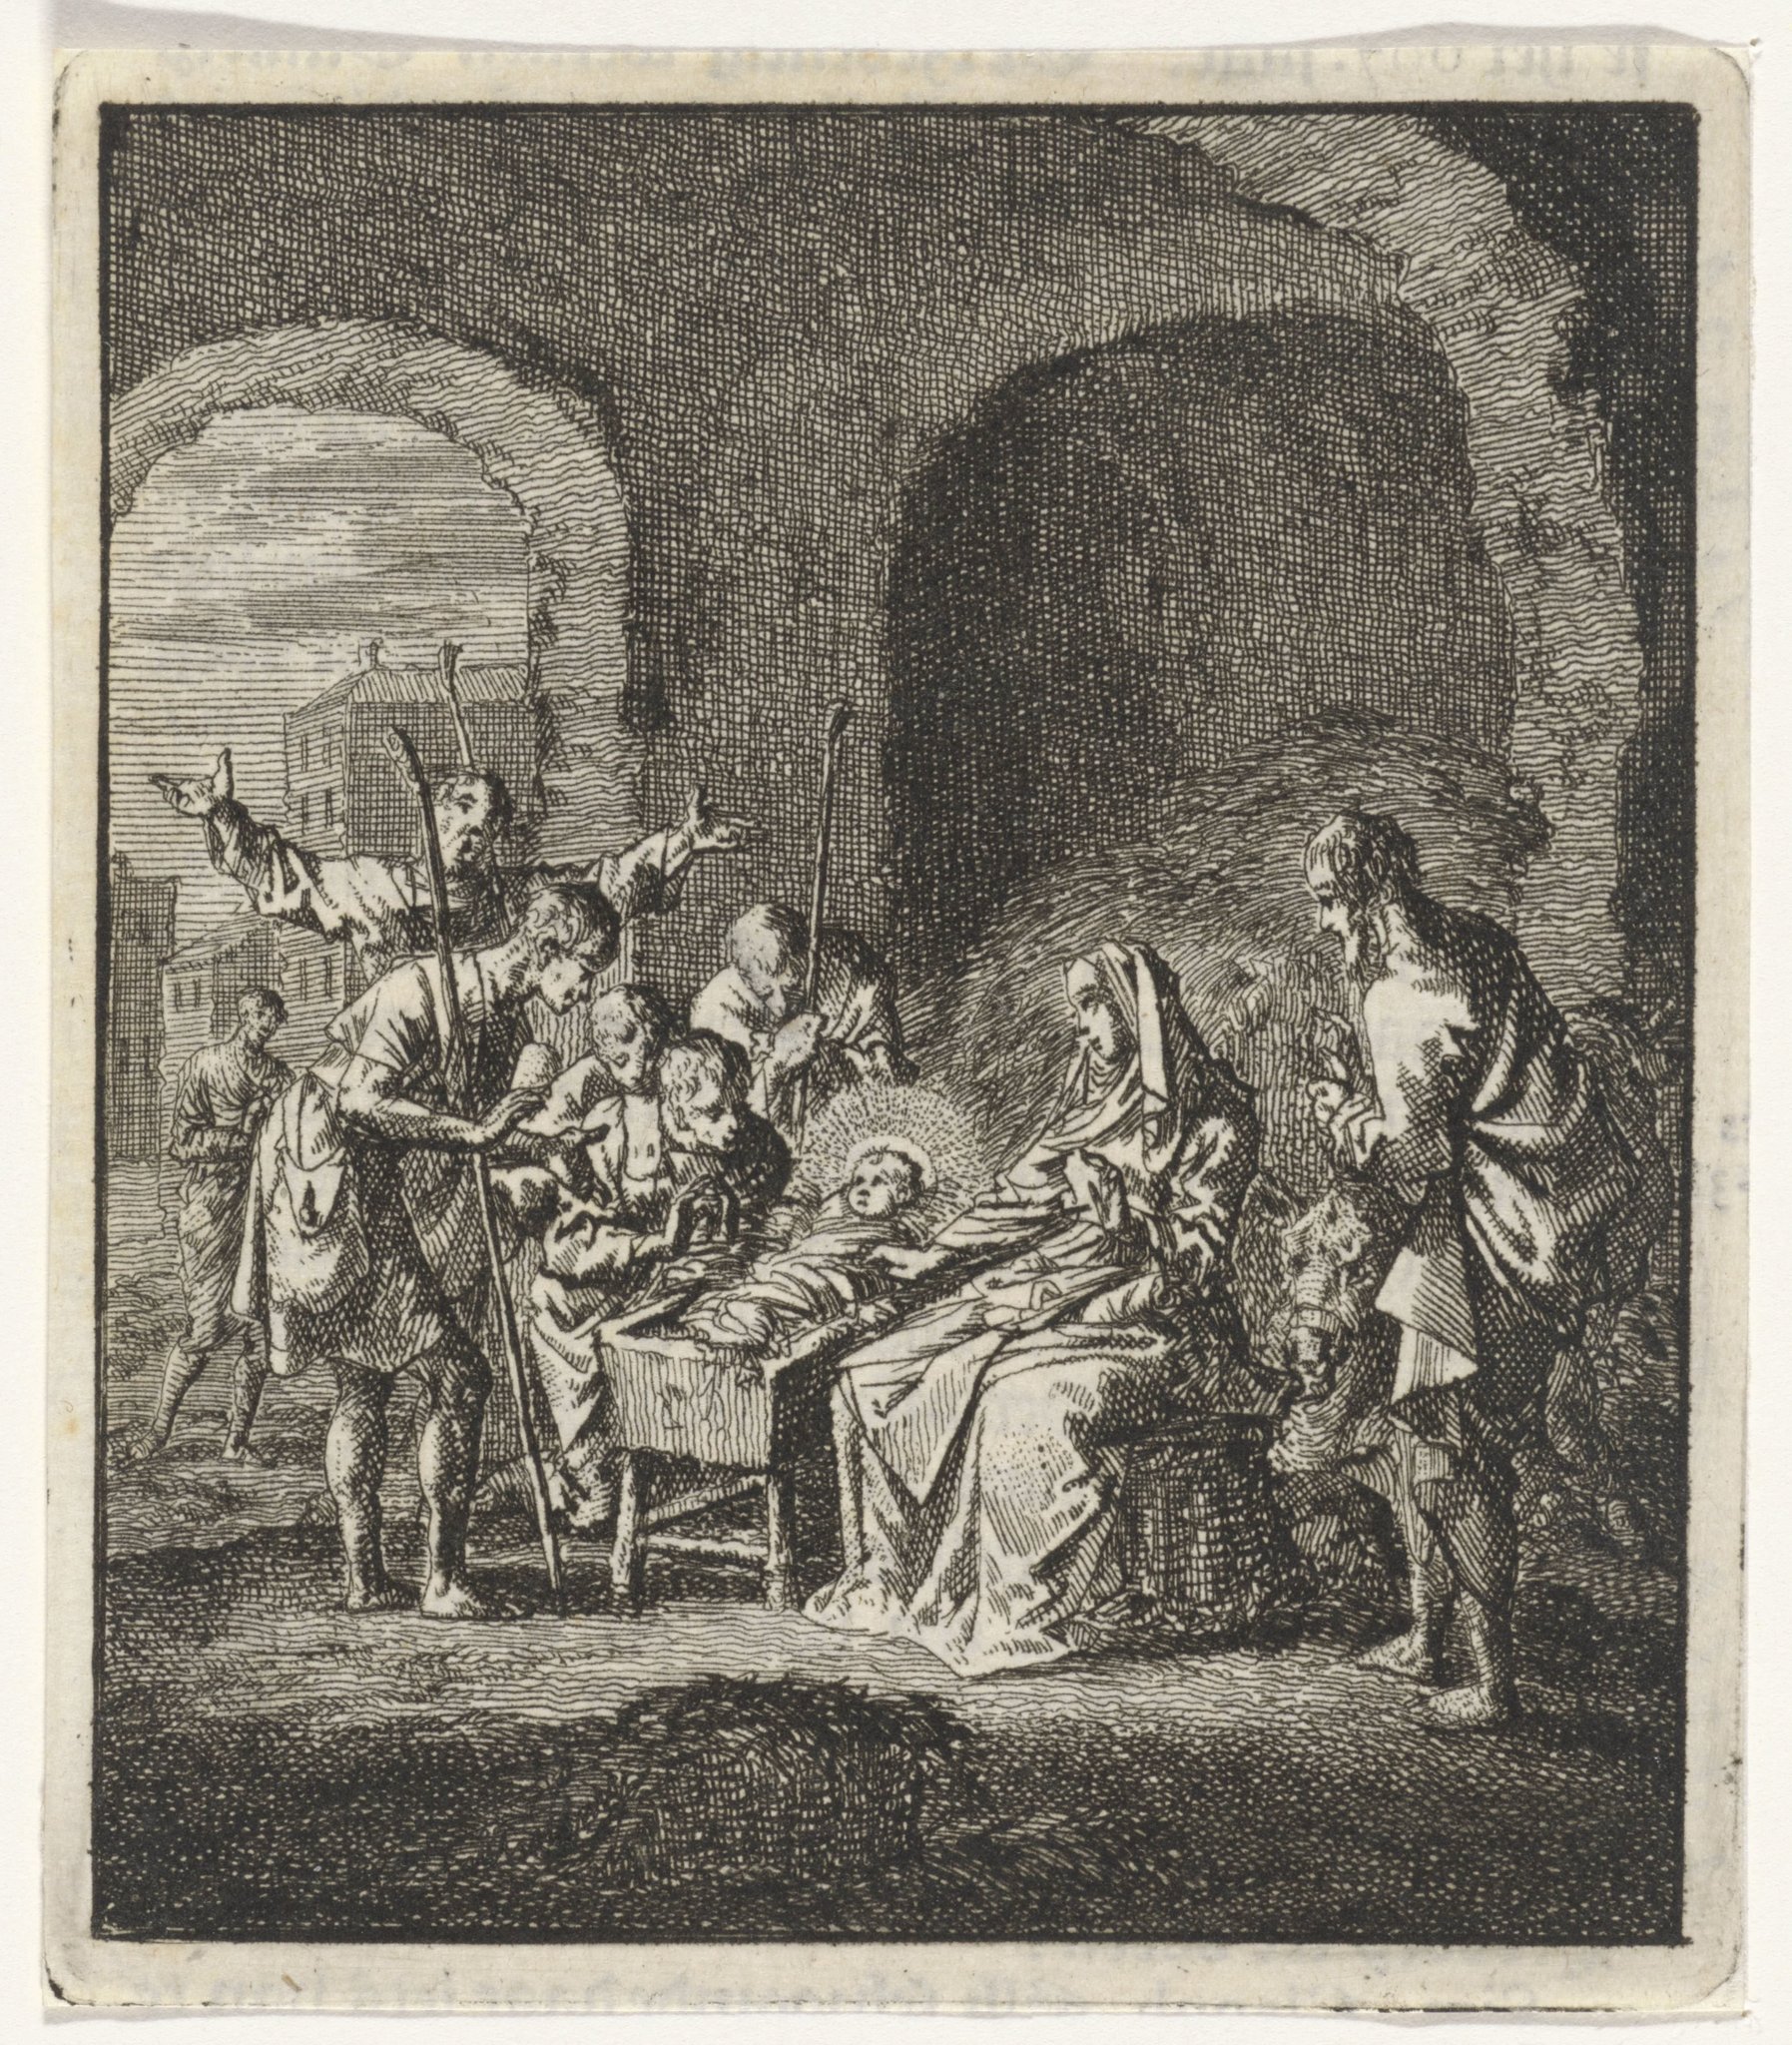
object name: print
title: Aanbidding der herders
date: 1706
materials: paper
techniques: etching, letterpress printing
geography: amsterdam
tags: adoration of the christ-child by the shepherds; mary and joseph present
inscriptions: collector's mark: Lugt 2228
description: Illustratie voor: Schabaalje, Jean Philipsz. De vermeerderde lust-hof des gemoeds. Amsterdam: Jan Rieuwertsz. (II) en Barent Visscher, 1706, p. 323.